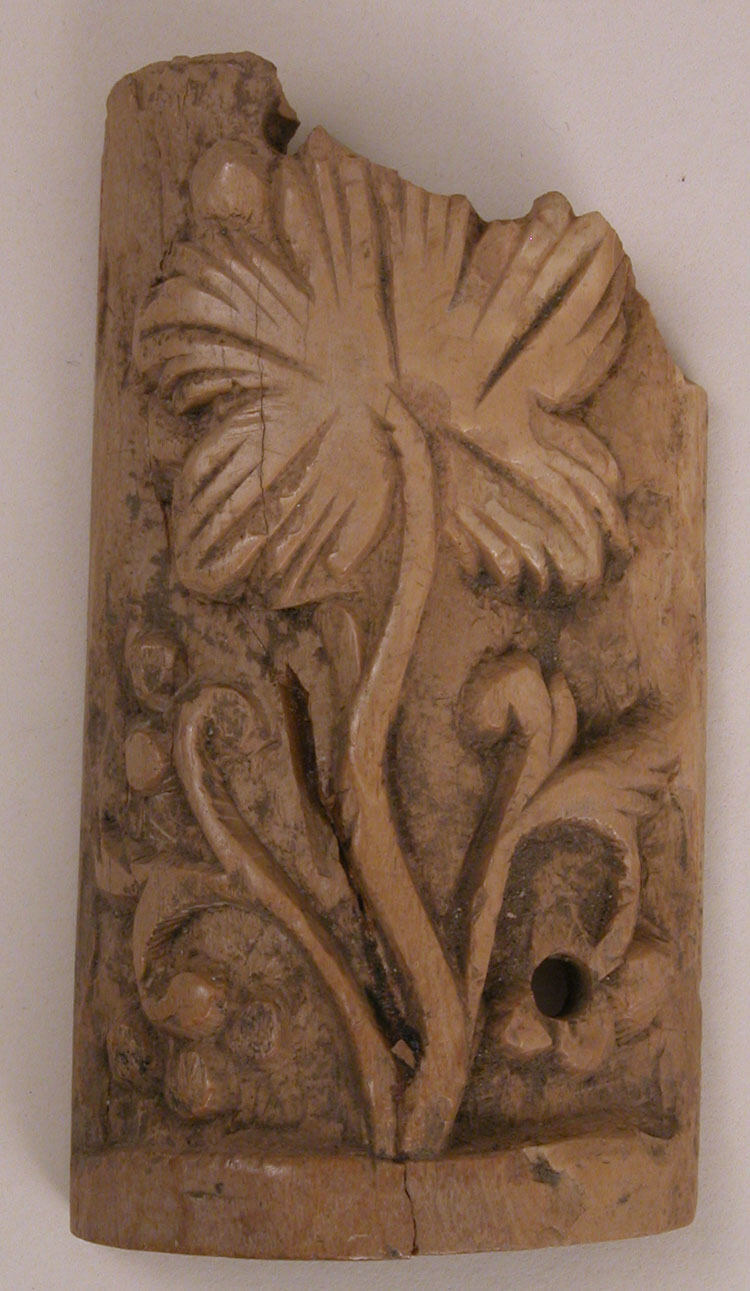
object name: plaque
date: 501-600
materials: bone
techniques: carving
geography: egypt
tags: flowers,leaves